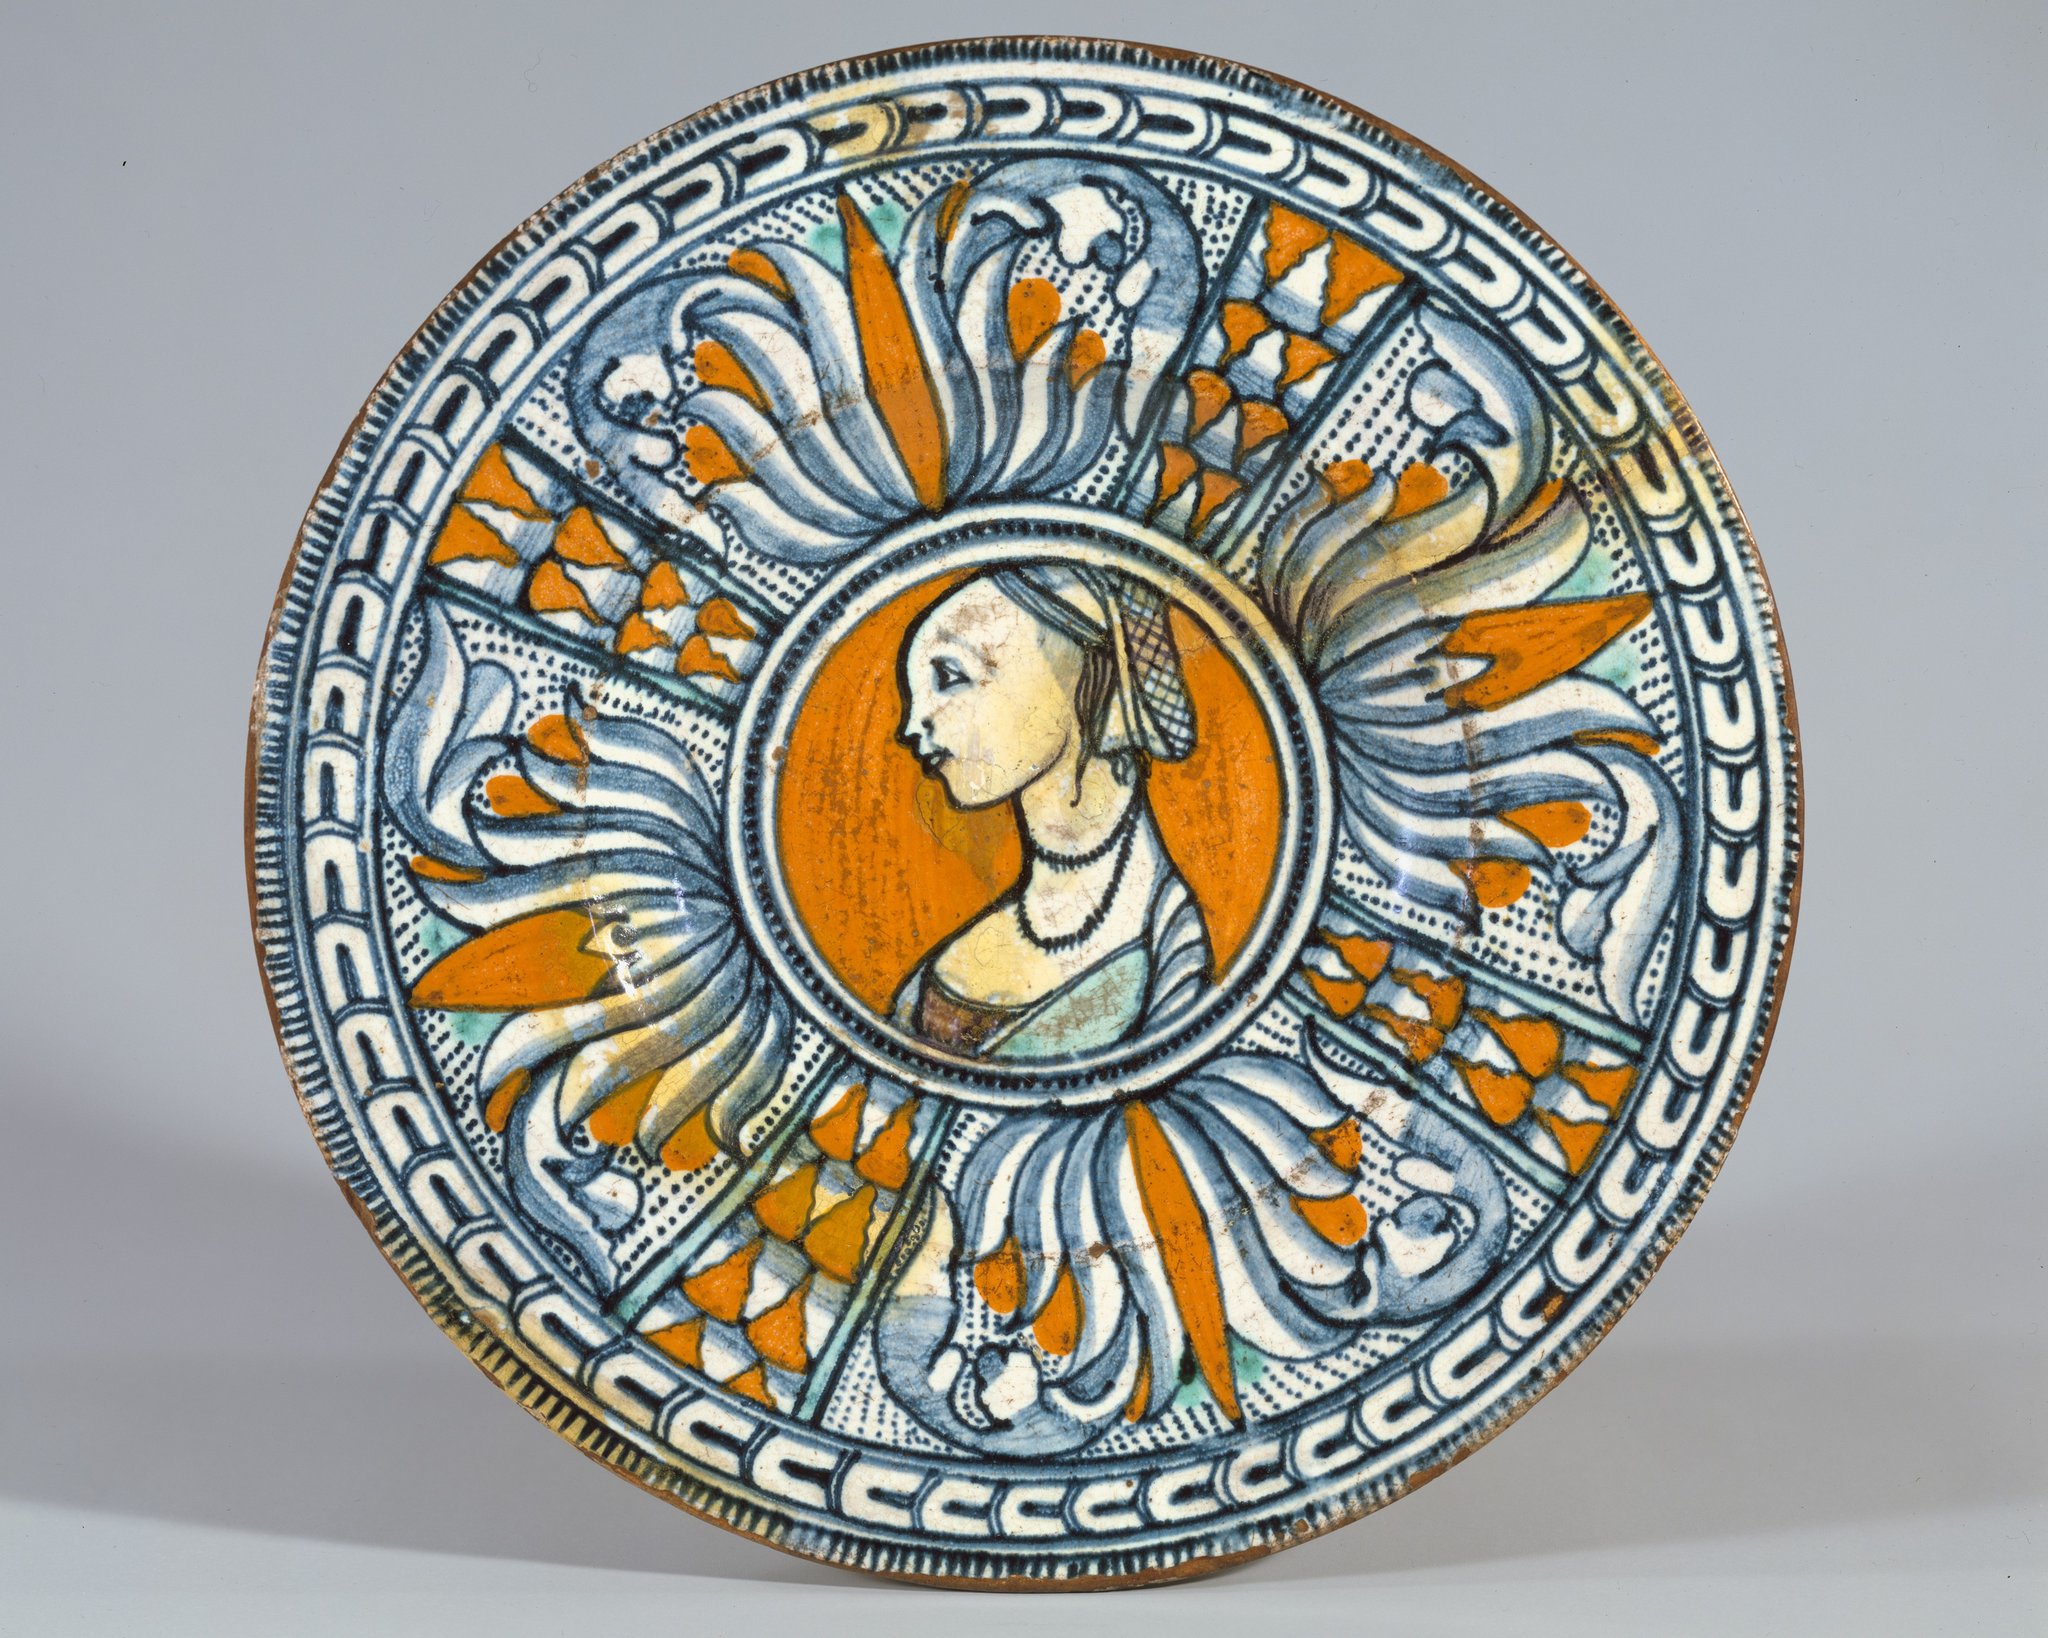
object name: plate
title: Plate (tagliere)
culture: italian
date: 1500-1510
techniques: maiolica, glazing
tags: profiles,women